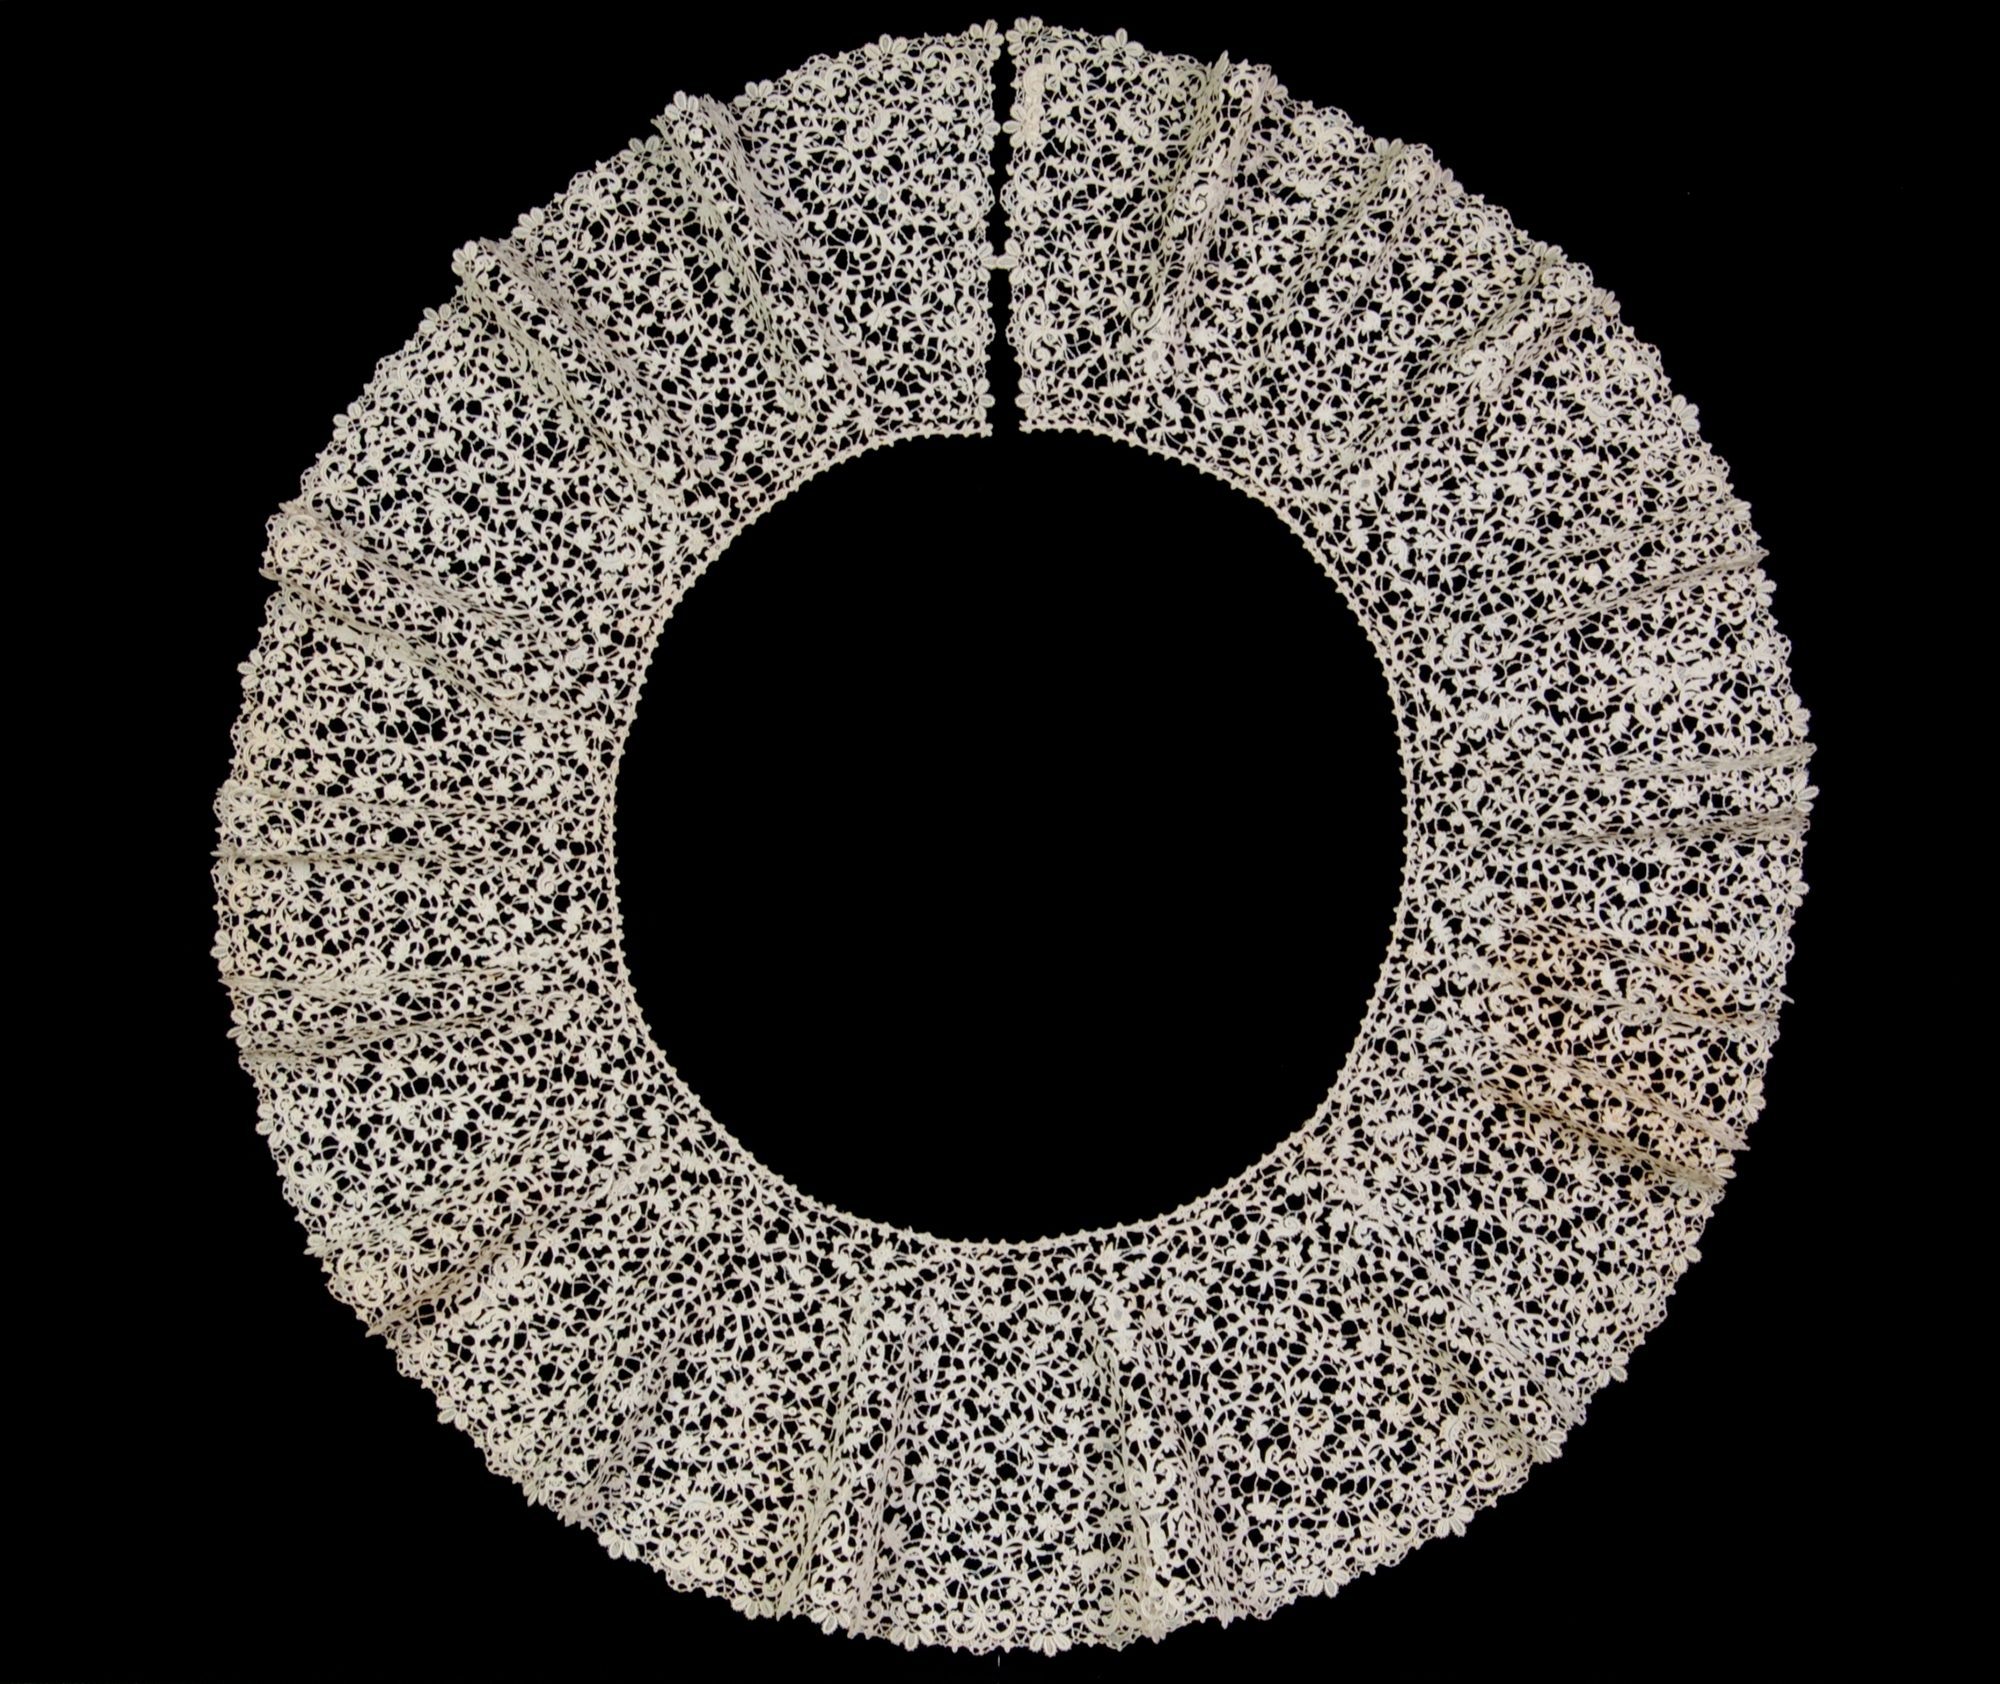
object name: bertha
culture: italian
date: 1890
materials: linen